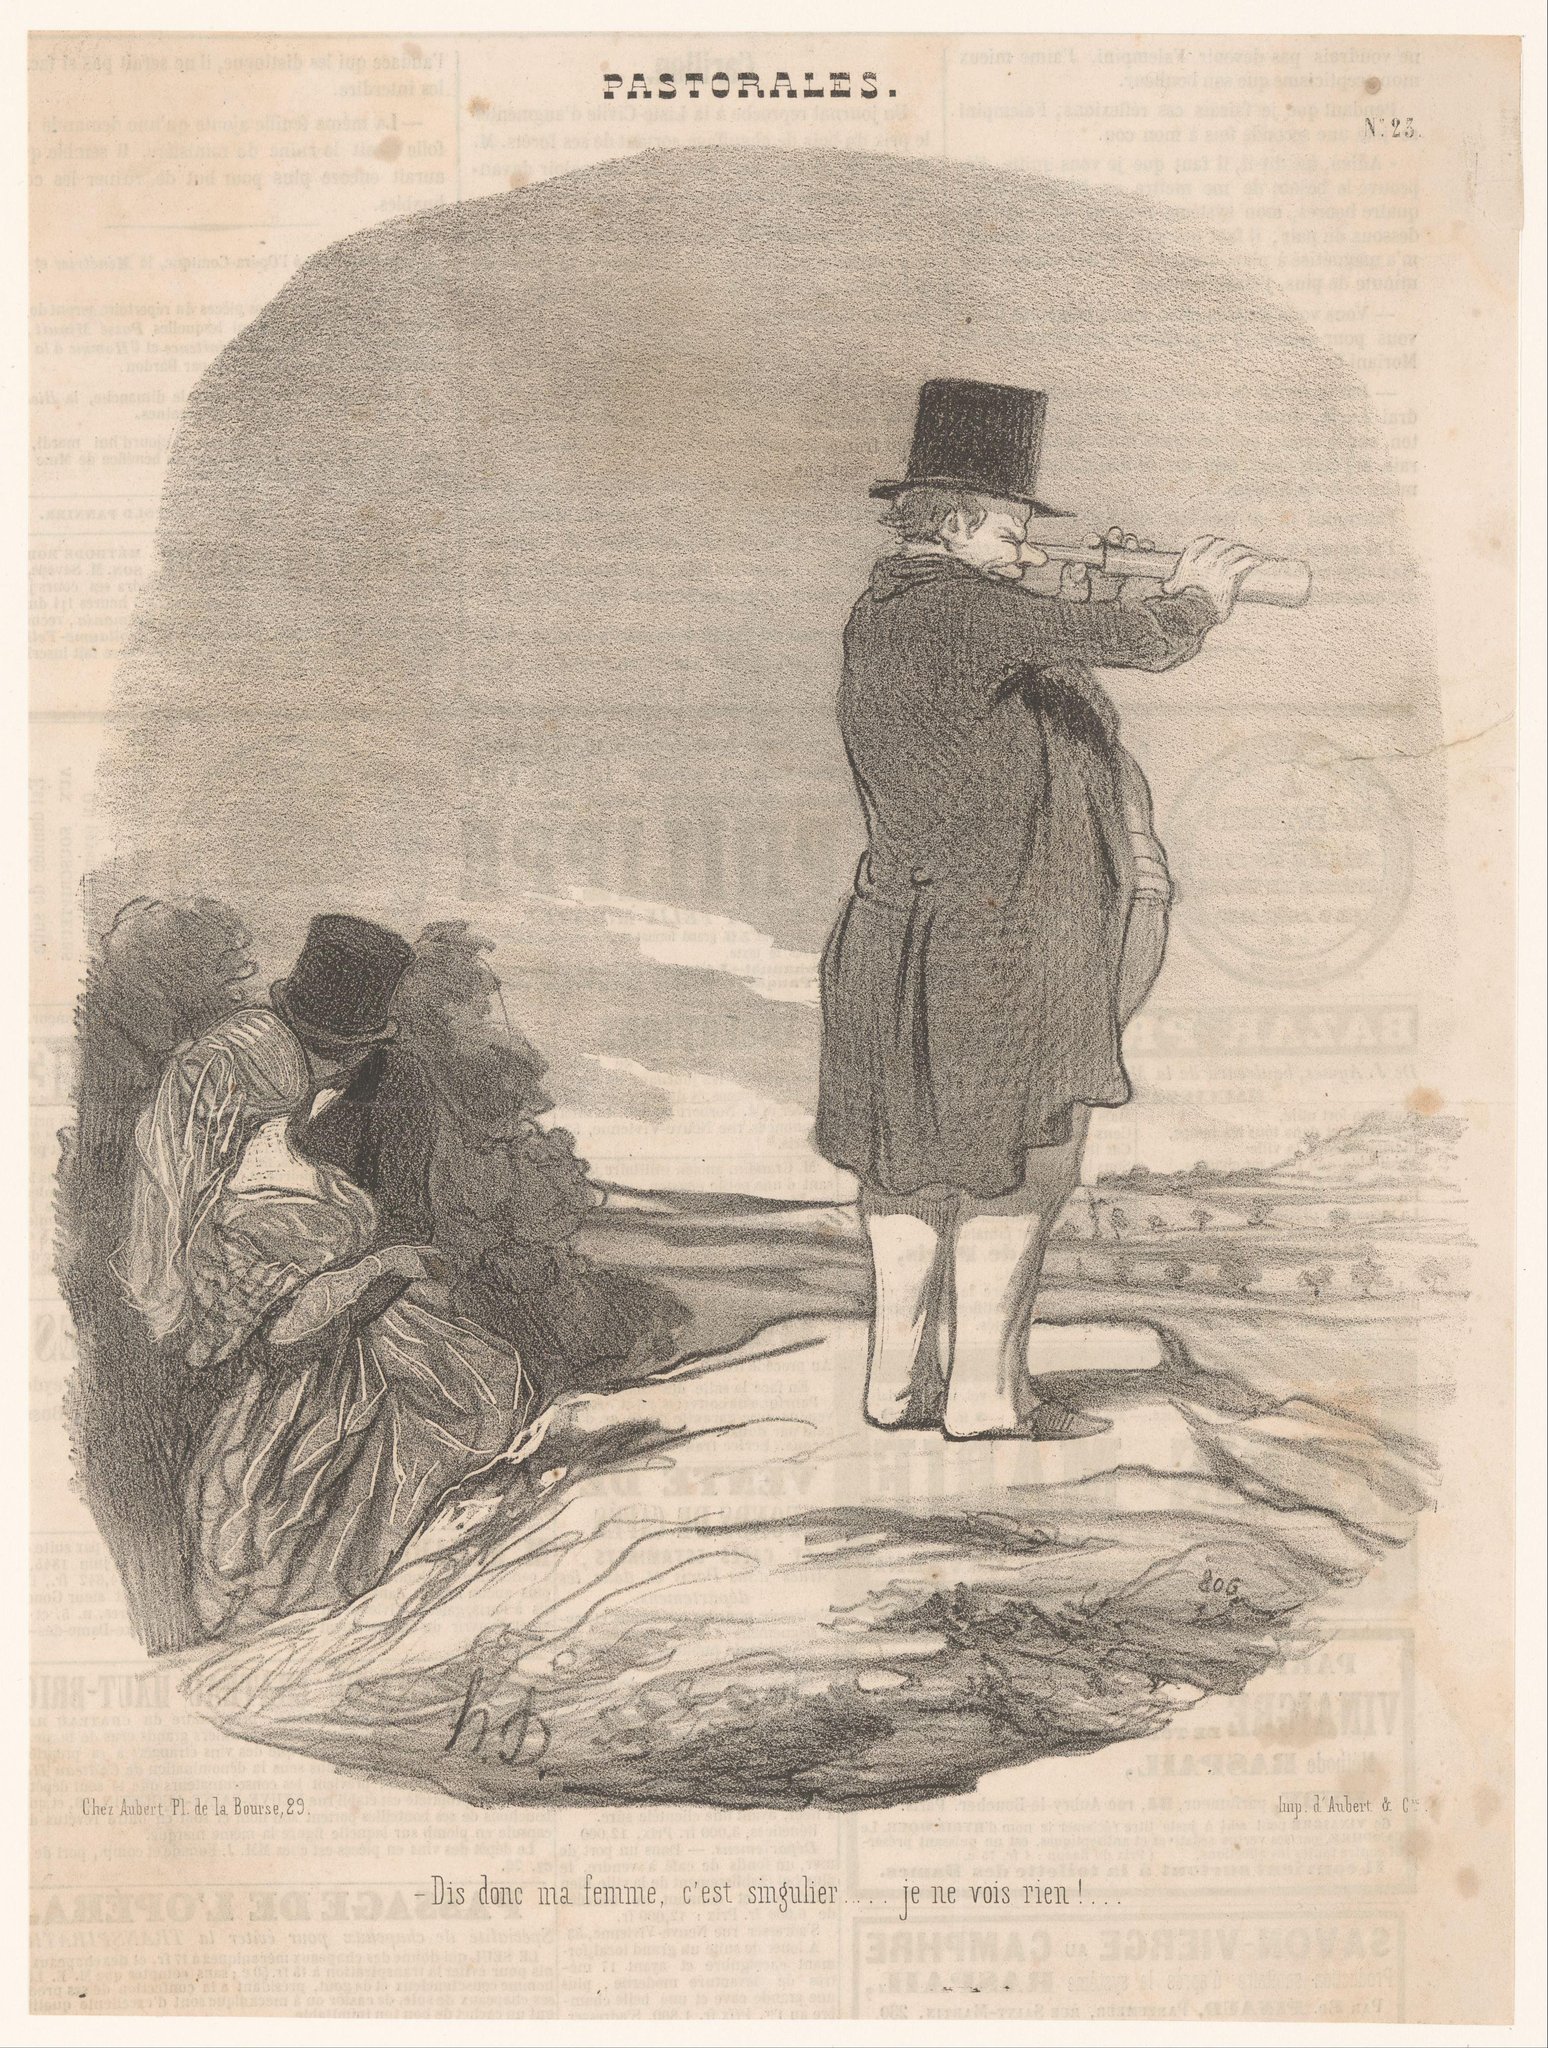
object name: cartoon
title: Pastorales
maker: honoré daumier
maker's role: draughtsman, painter, print maker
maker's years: 1808-1879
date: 1845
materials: paper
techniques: lithograph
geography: paris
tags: caricatures (human types), (lovers) kissing each other, satire on marriage, binoculars, spy-glass, etc.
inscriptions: collector's mark: Lugt 2228a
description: Prent gebruikt voor: Le Charivari, 07-10-1845.